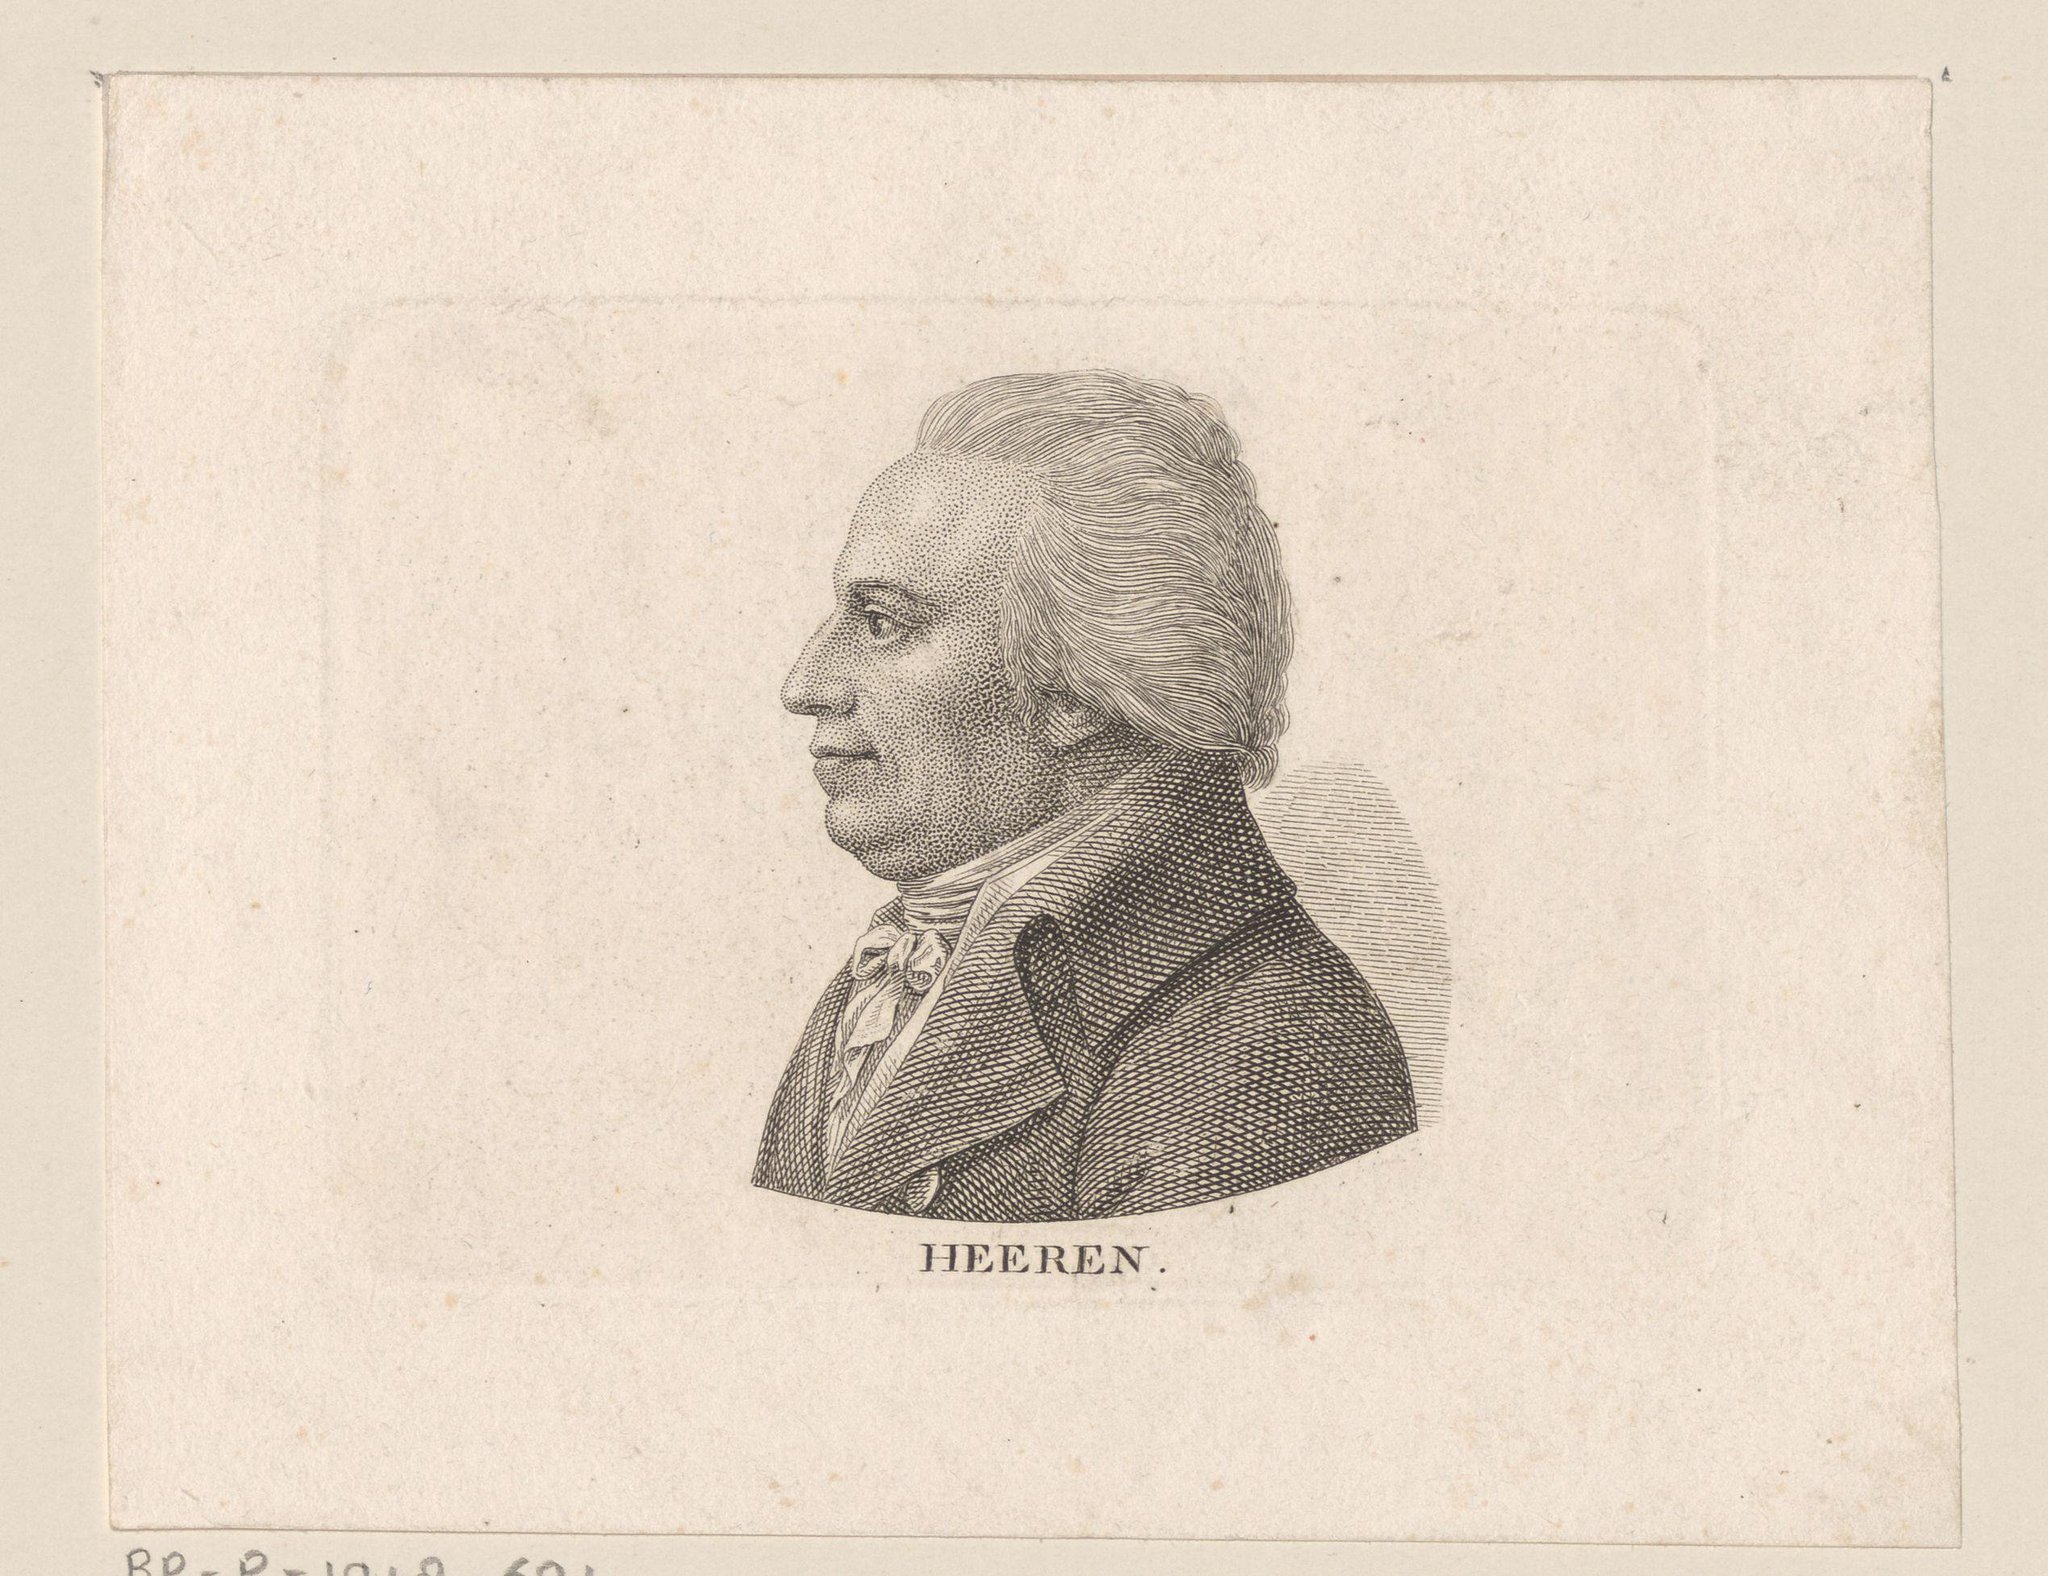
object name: print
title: Portret van Arnold Hermann Ludwig Heeren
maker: ernst ludwig riepenhausen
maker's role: print maker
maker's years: 1765-1840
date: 1800-1840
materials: paper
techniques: engraving, etching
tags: historical persons, professor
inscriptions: collector's mark: Lugt 2233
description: Prent mogelijk uit: Almanach der Georg-Augusts-Universität zu Göttingen auf das Jahr 1821. Lüneburg: Herold en Wahlstab, 1821.